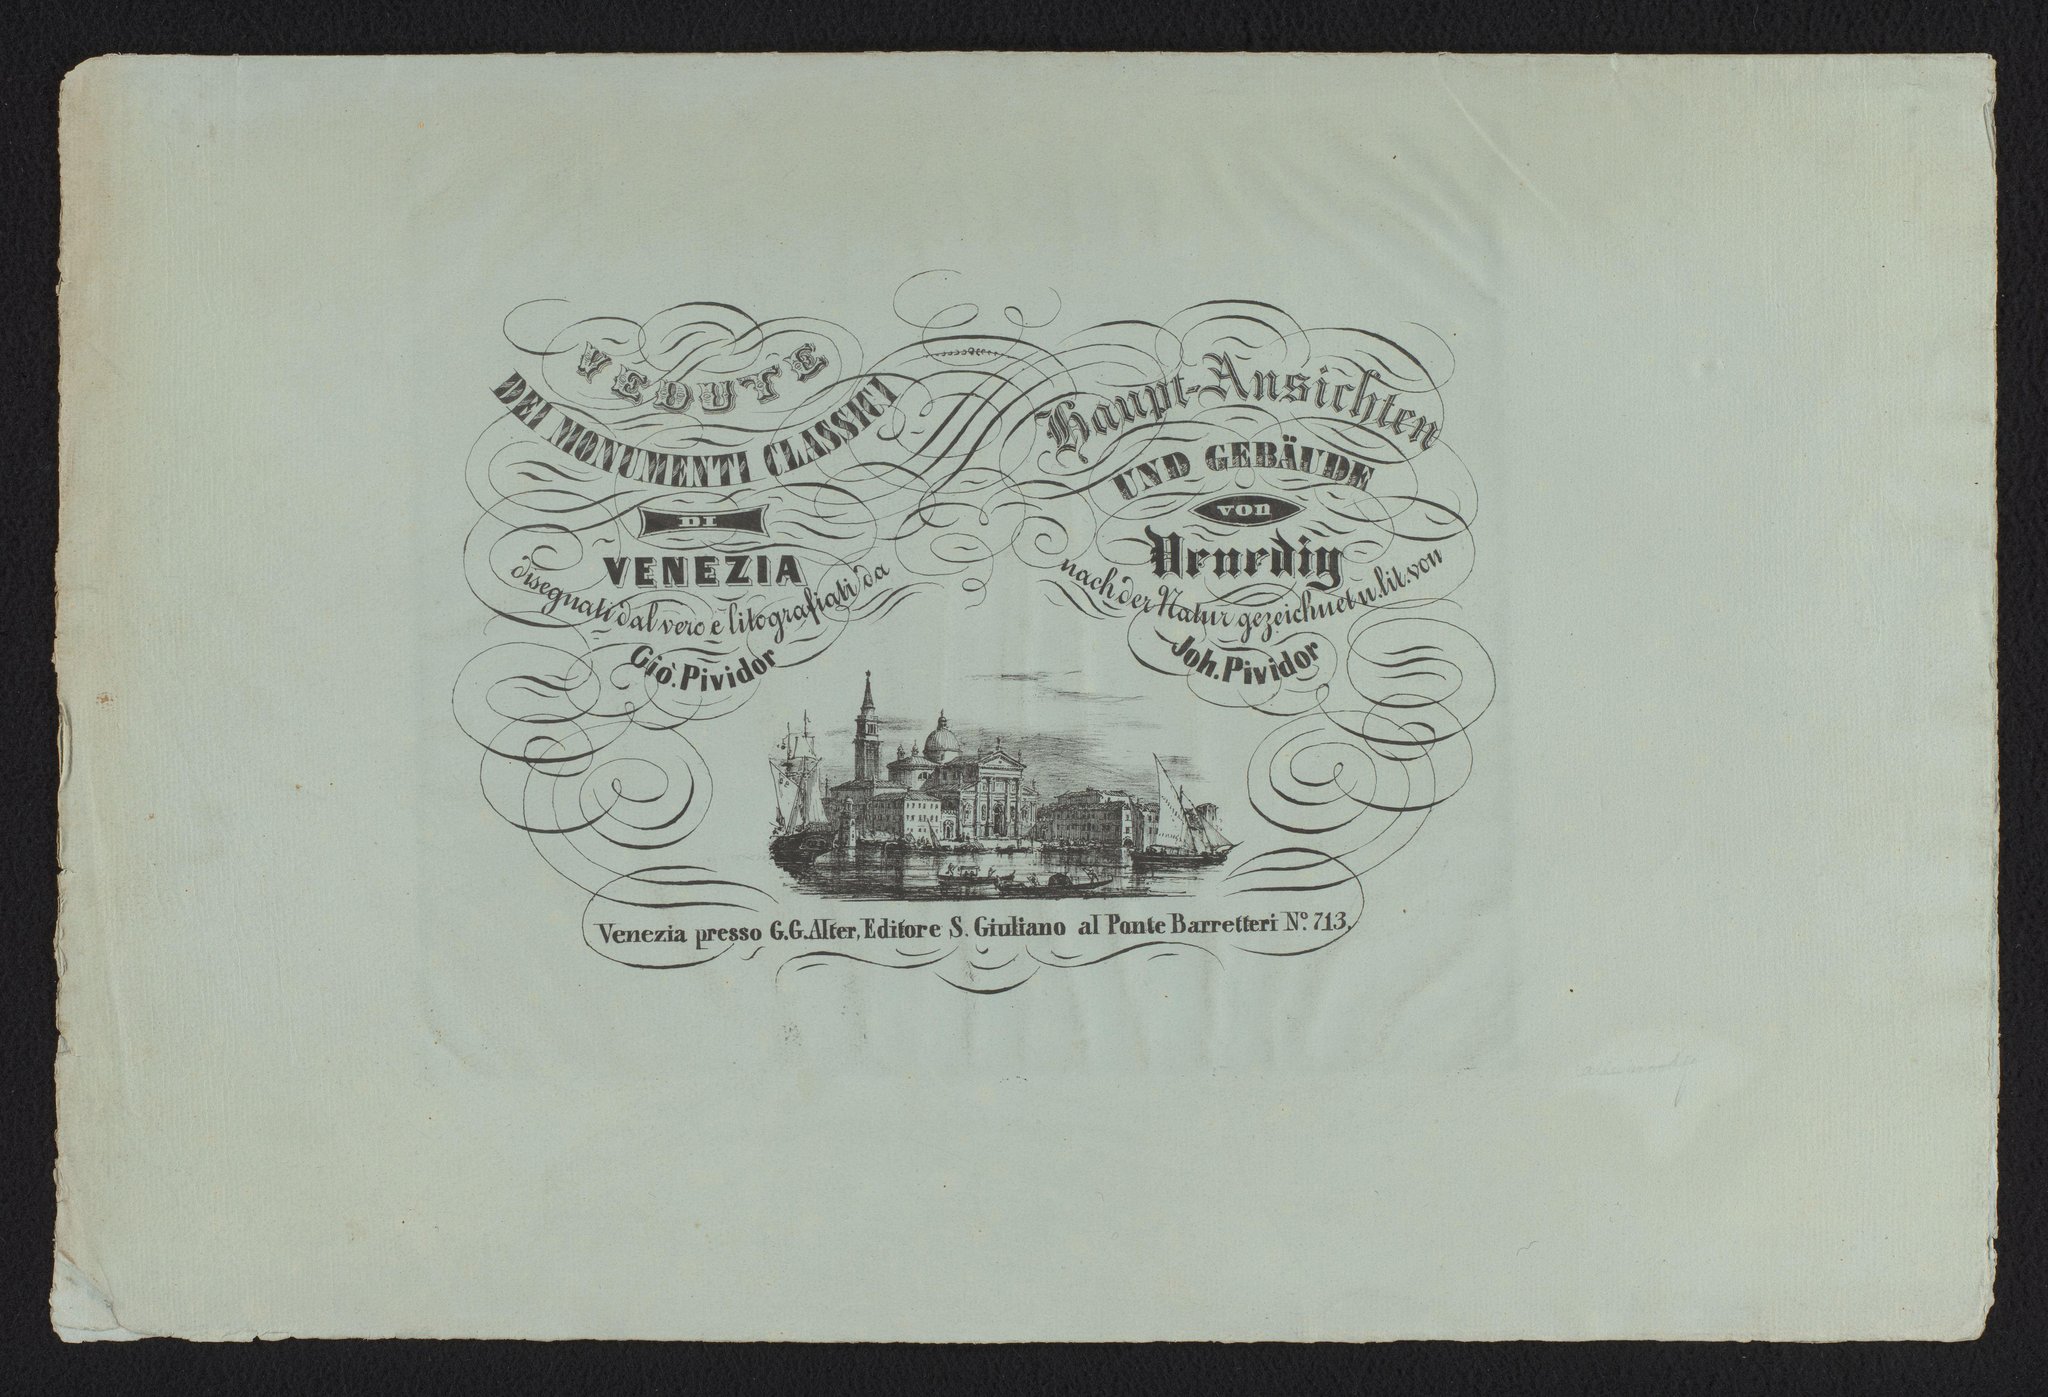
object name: print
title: Gezichten op monumenten in Venetië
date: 1826-1872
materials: paper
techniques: lithograph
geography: venice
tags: square, place, circus, etc., city-view, and landscape with man-made constructions, island, church (exterior)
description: Gezicht op de Chiesa di San Giorgio Maggiore op Isola di San Giorgio Maggiore aan het Canal Grande te Venetië. Titel in het Italiaans en in het Duits. Voorstelling is gevat in een sierlijst.